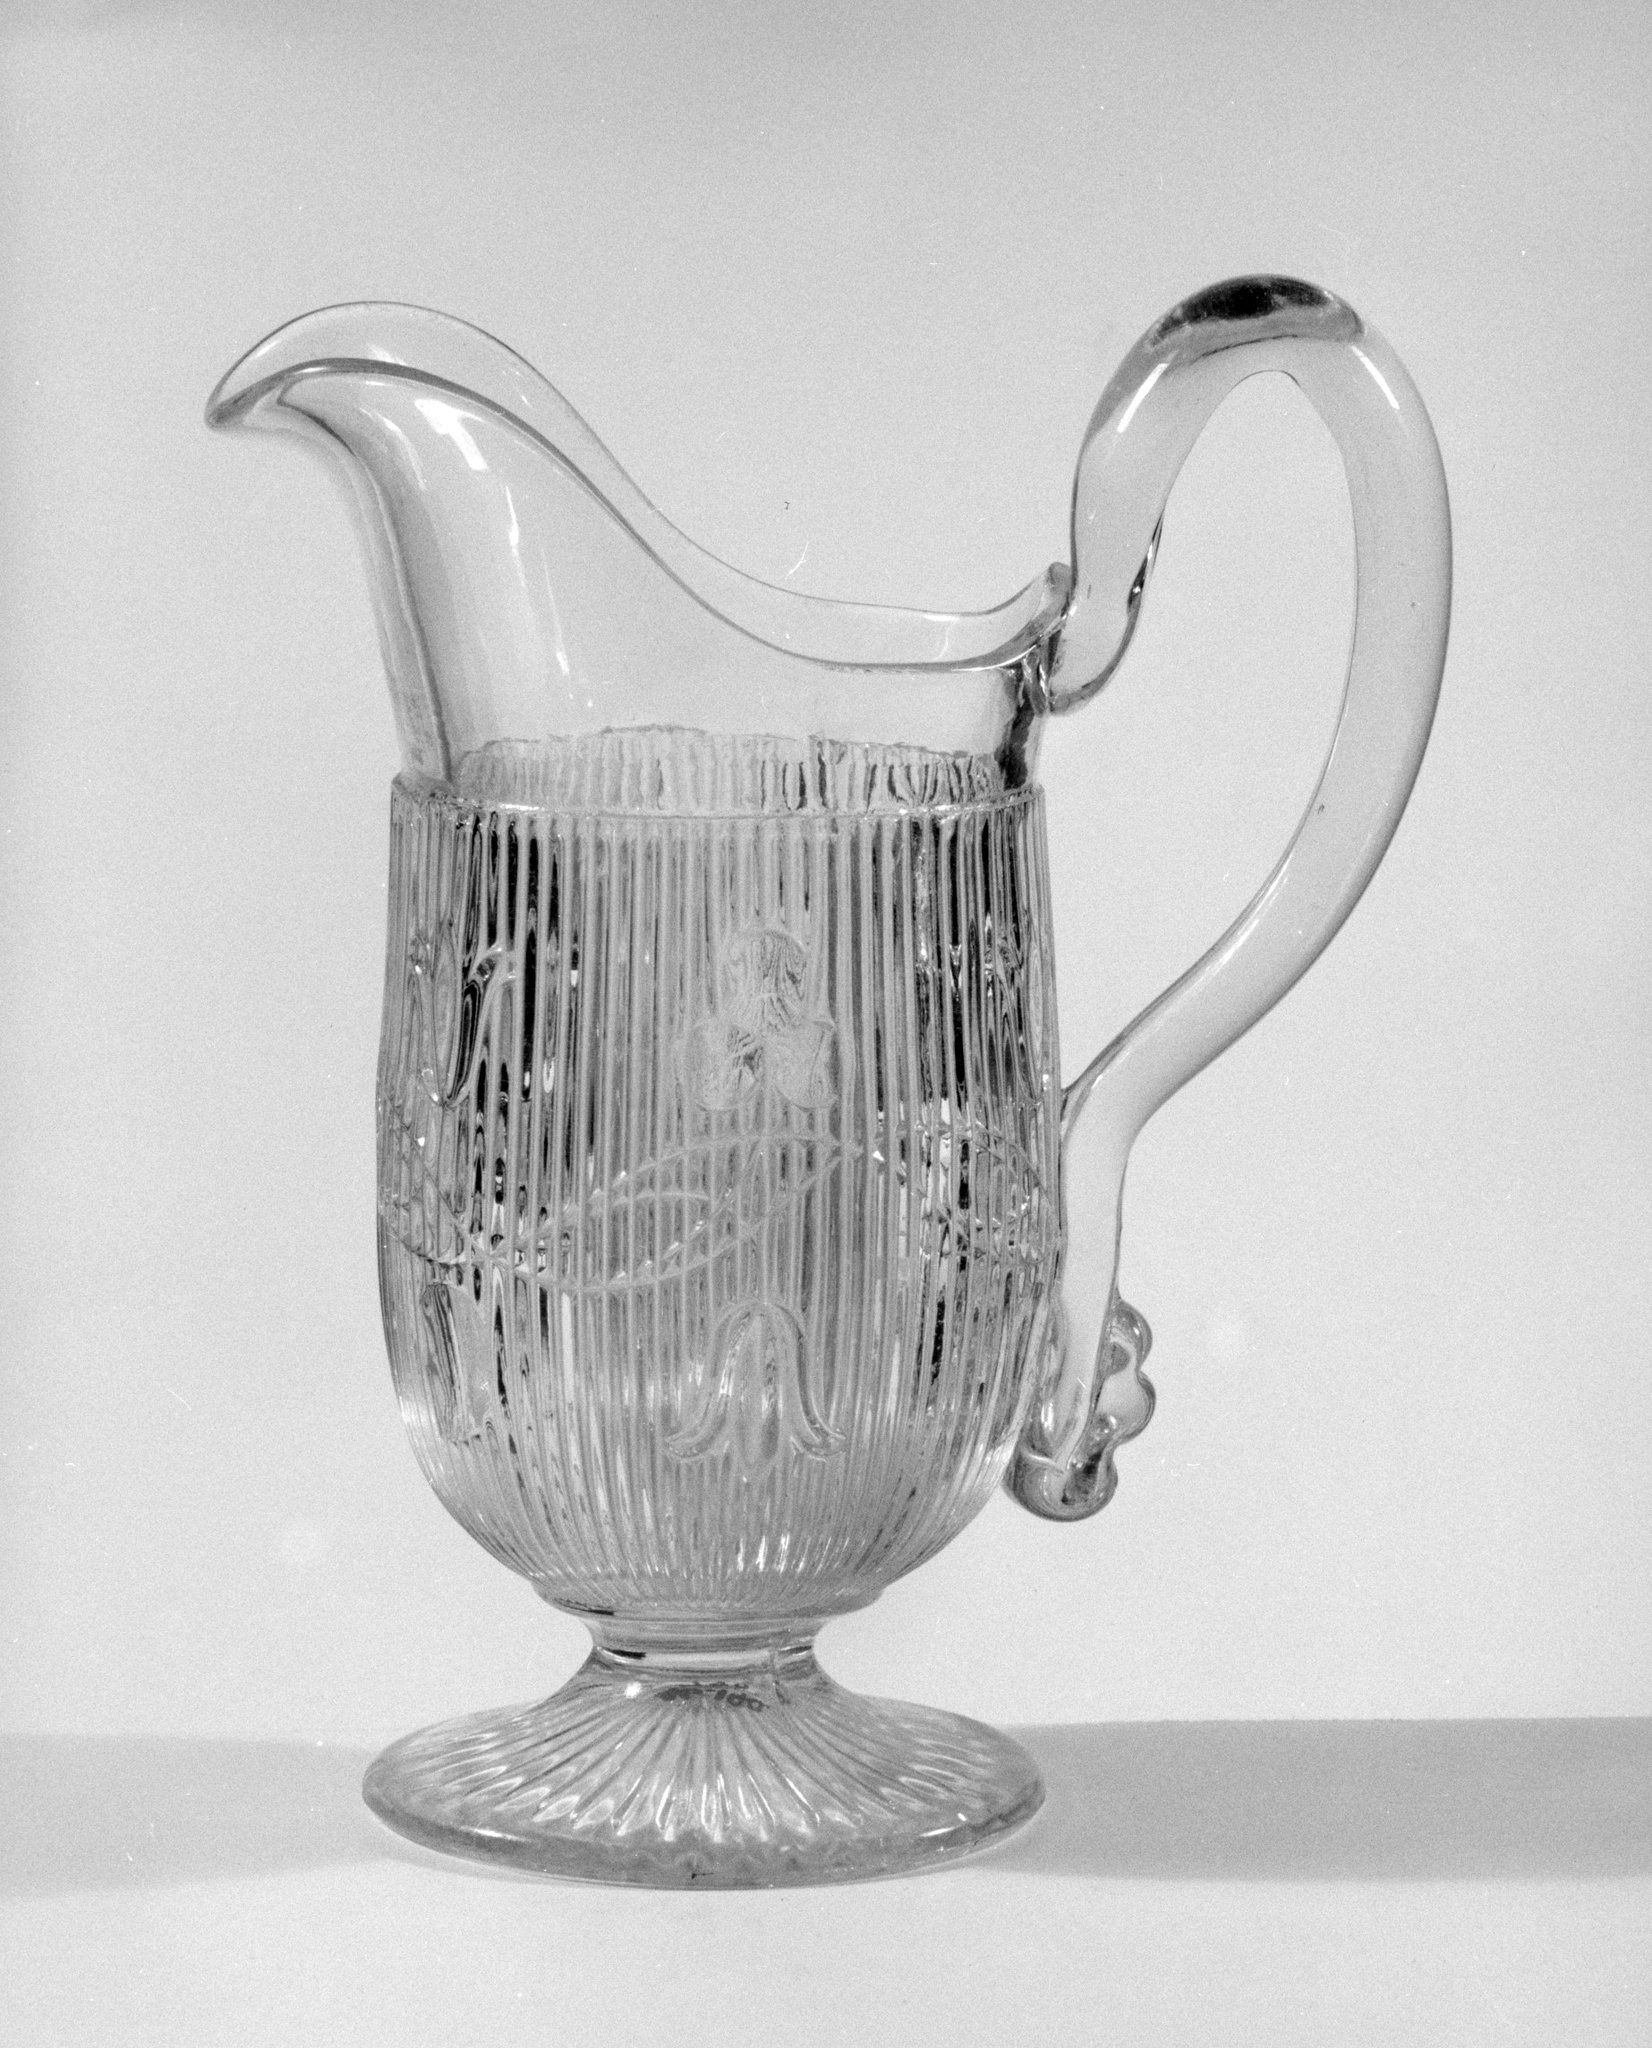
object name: pitcher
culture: american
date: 1850-1870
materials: glass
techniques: pressed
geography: united states